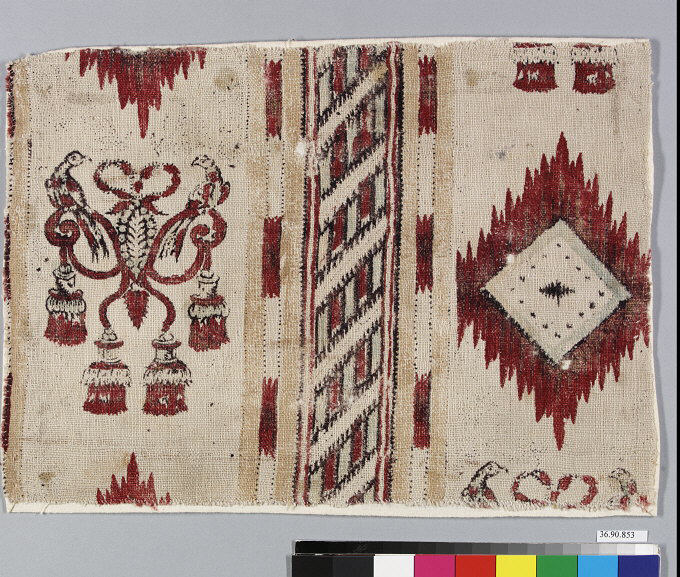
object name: piece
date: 1701-1800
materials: cotton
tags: birds